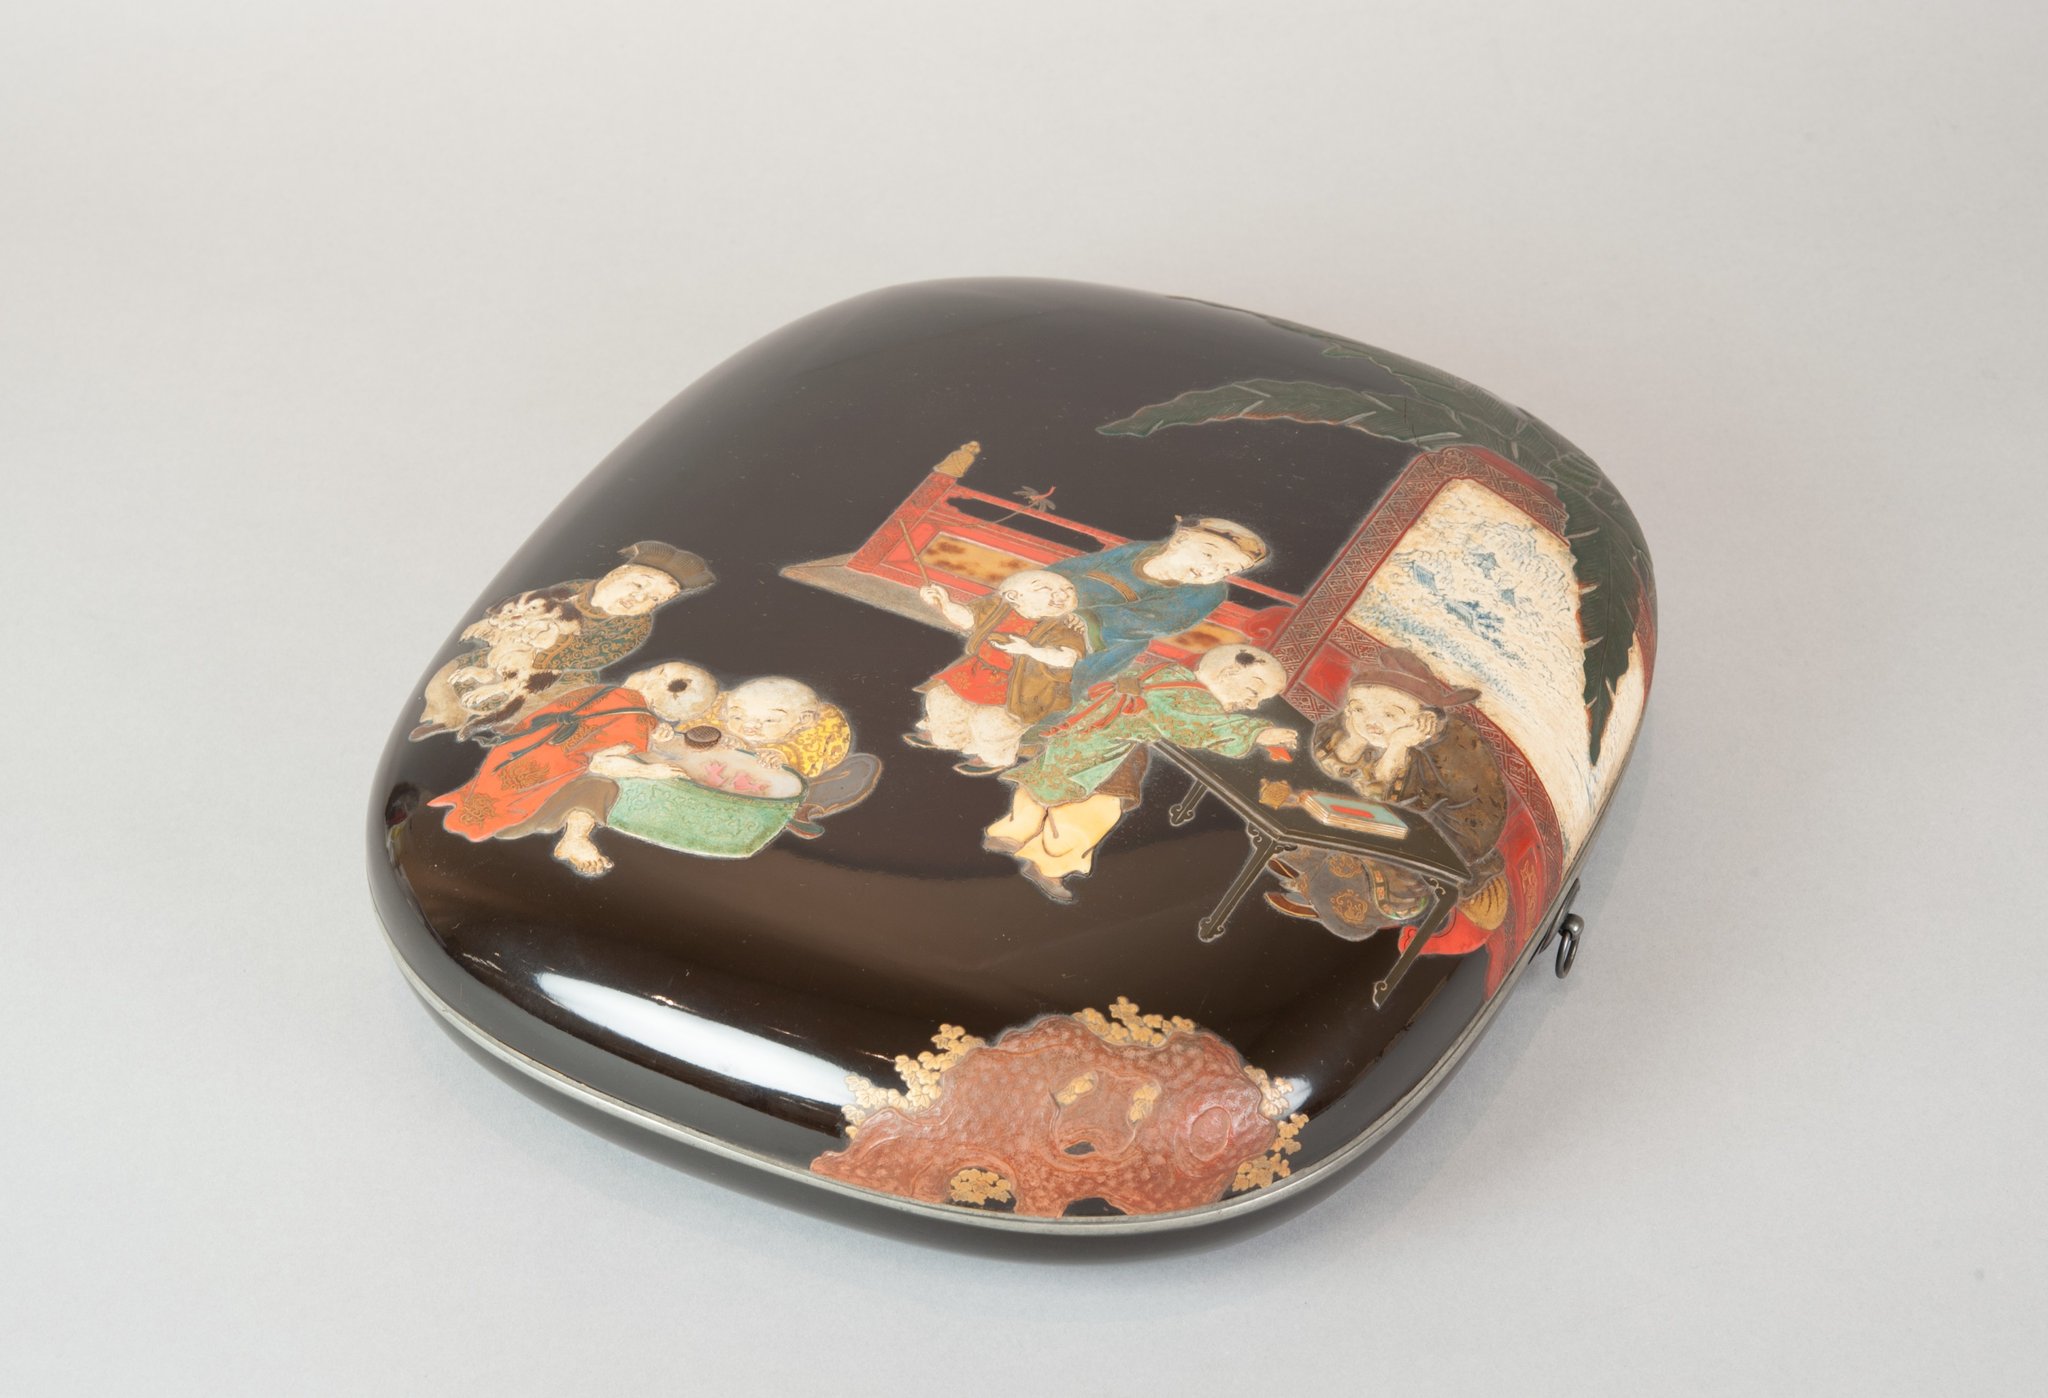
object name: document box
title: Document Box with Design of Chinese Children at Play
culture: japanese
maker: ogawa haritsu (ritsuō)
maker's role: artist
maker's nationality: japanese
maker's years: 1663-1747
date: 1801-1900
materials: ceramic, foil, gold, ivory, lacquer, mother of pearl, silver, shell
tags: boys,playing